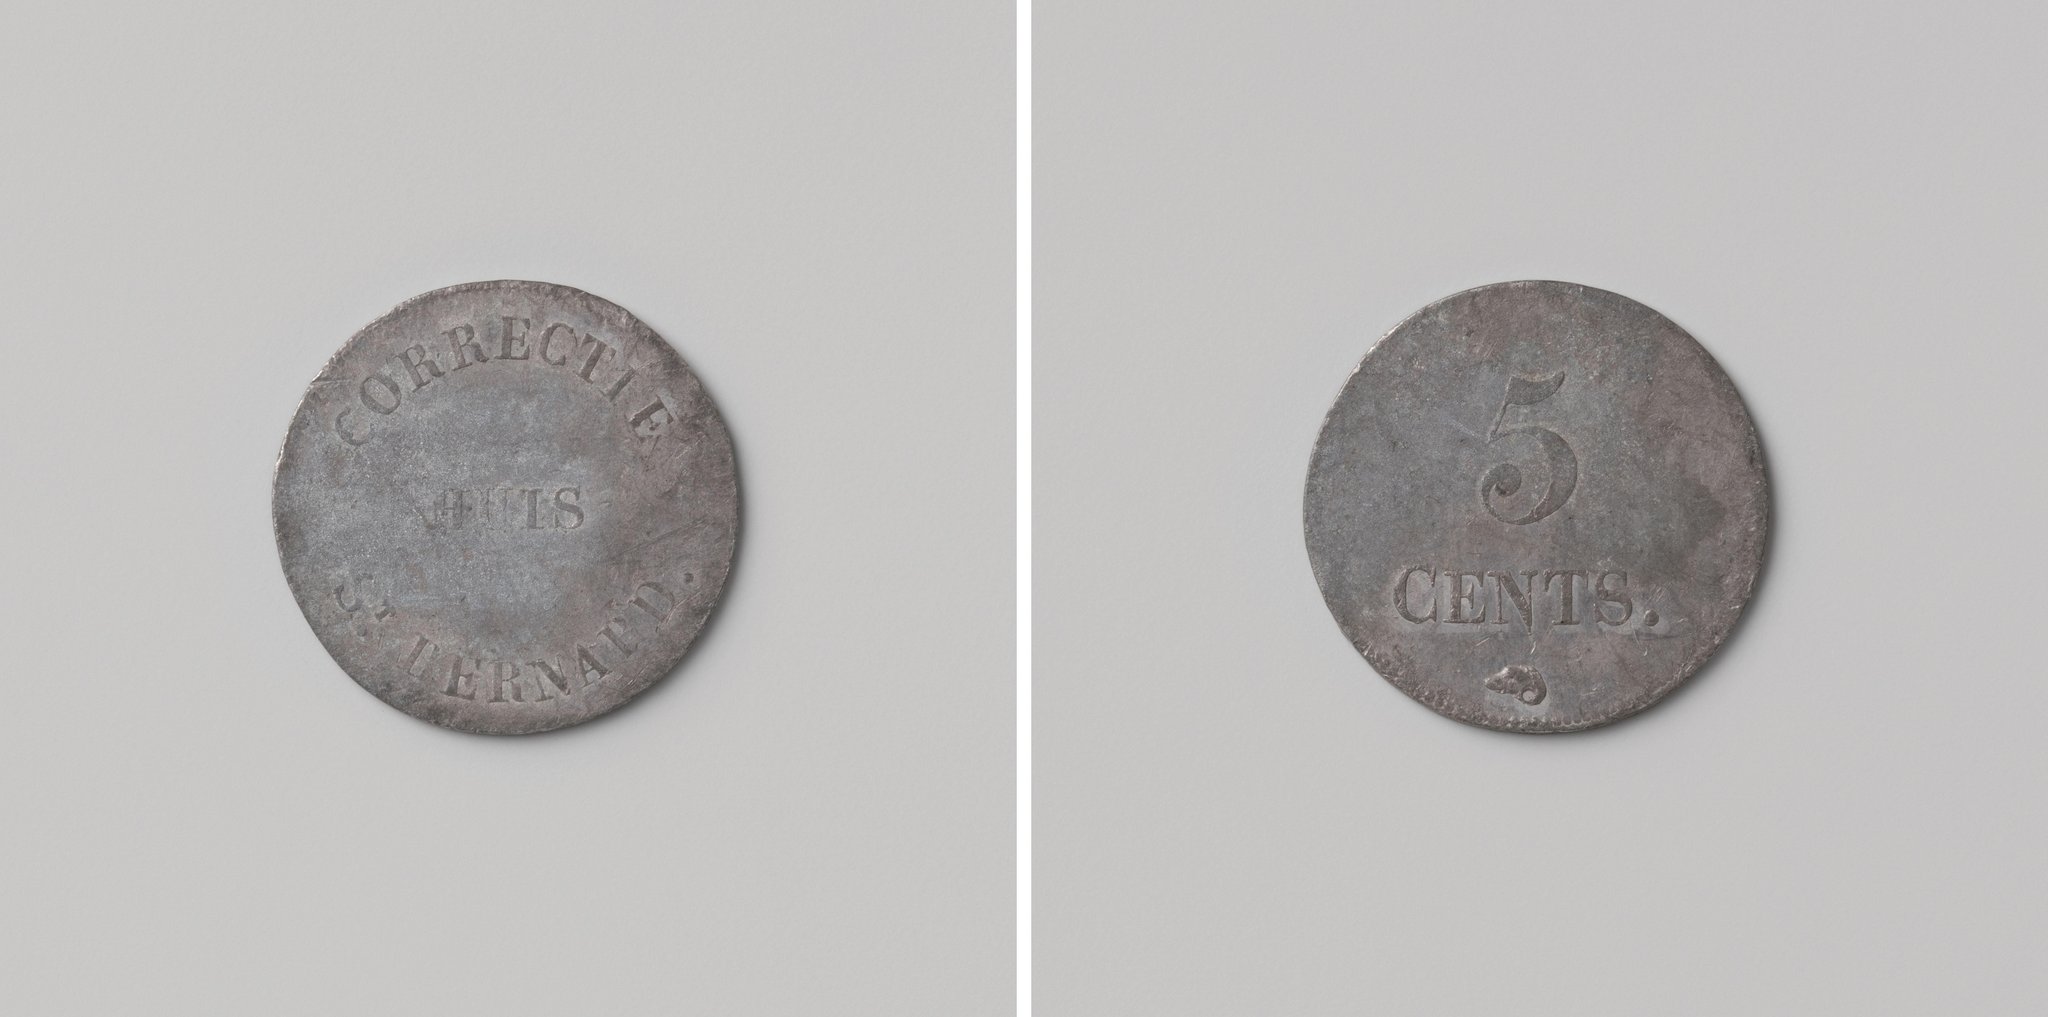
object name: monetary token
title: Correctiehuis Sint Bernhard te Hemiksem, huismunt ter waarde van vijf cents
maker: joseph pierre braemt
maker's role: print maker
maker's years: 1796-1864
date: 1826-1833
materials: zinc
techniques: striking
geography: brussels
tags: ghent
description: Zinken betaalpenning. Voorzijde: opschrift binnen omschrift. Keerzijde: waardeaanduiding.